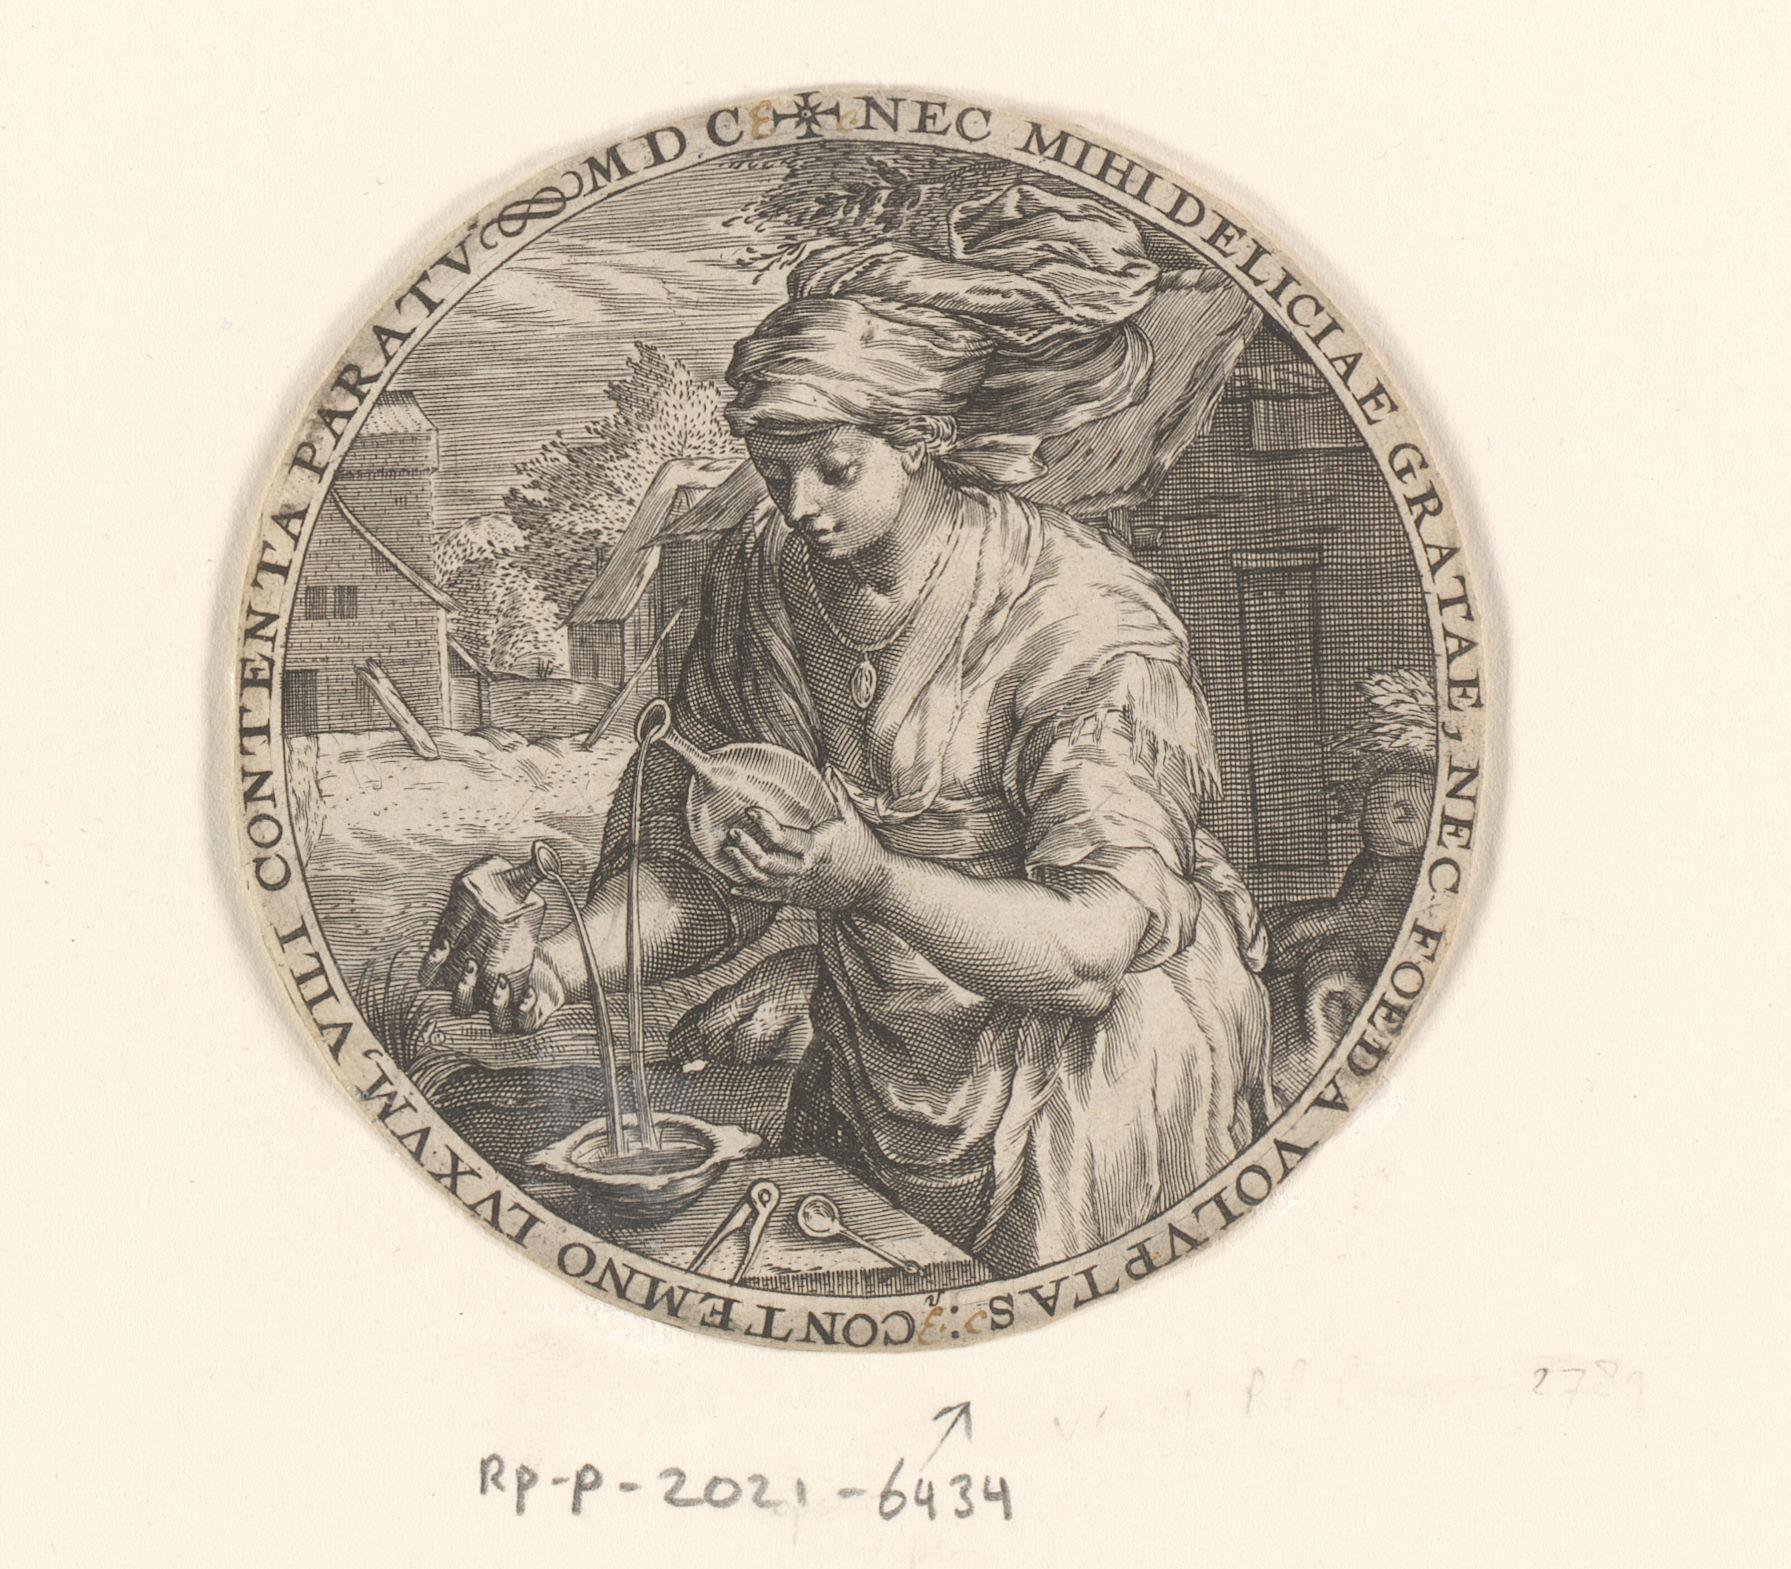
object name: print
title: Theologische deugden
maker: crispijn van de passe (i)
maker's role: draughtsman, print maker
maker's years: 1564-1637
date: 1600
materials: paper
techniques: engraving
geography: cologne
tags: temperance, 'temperantia'; 'temperanza' (ripa) ~ one of the four cardinal virtues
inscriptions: monogram: ‘EC’